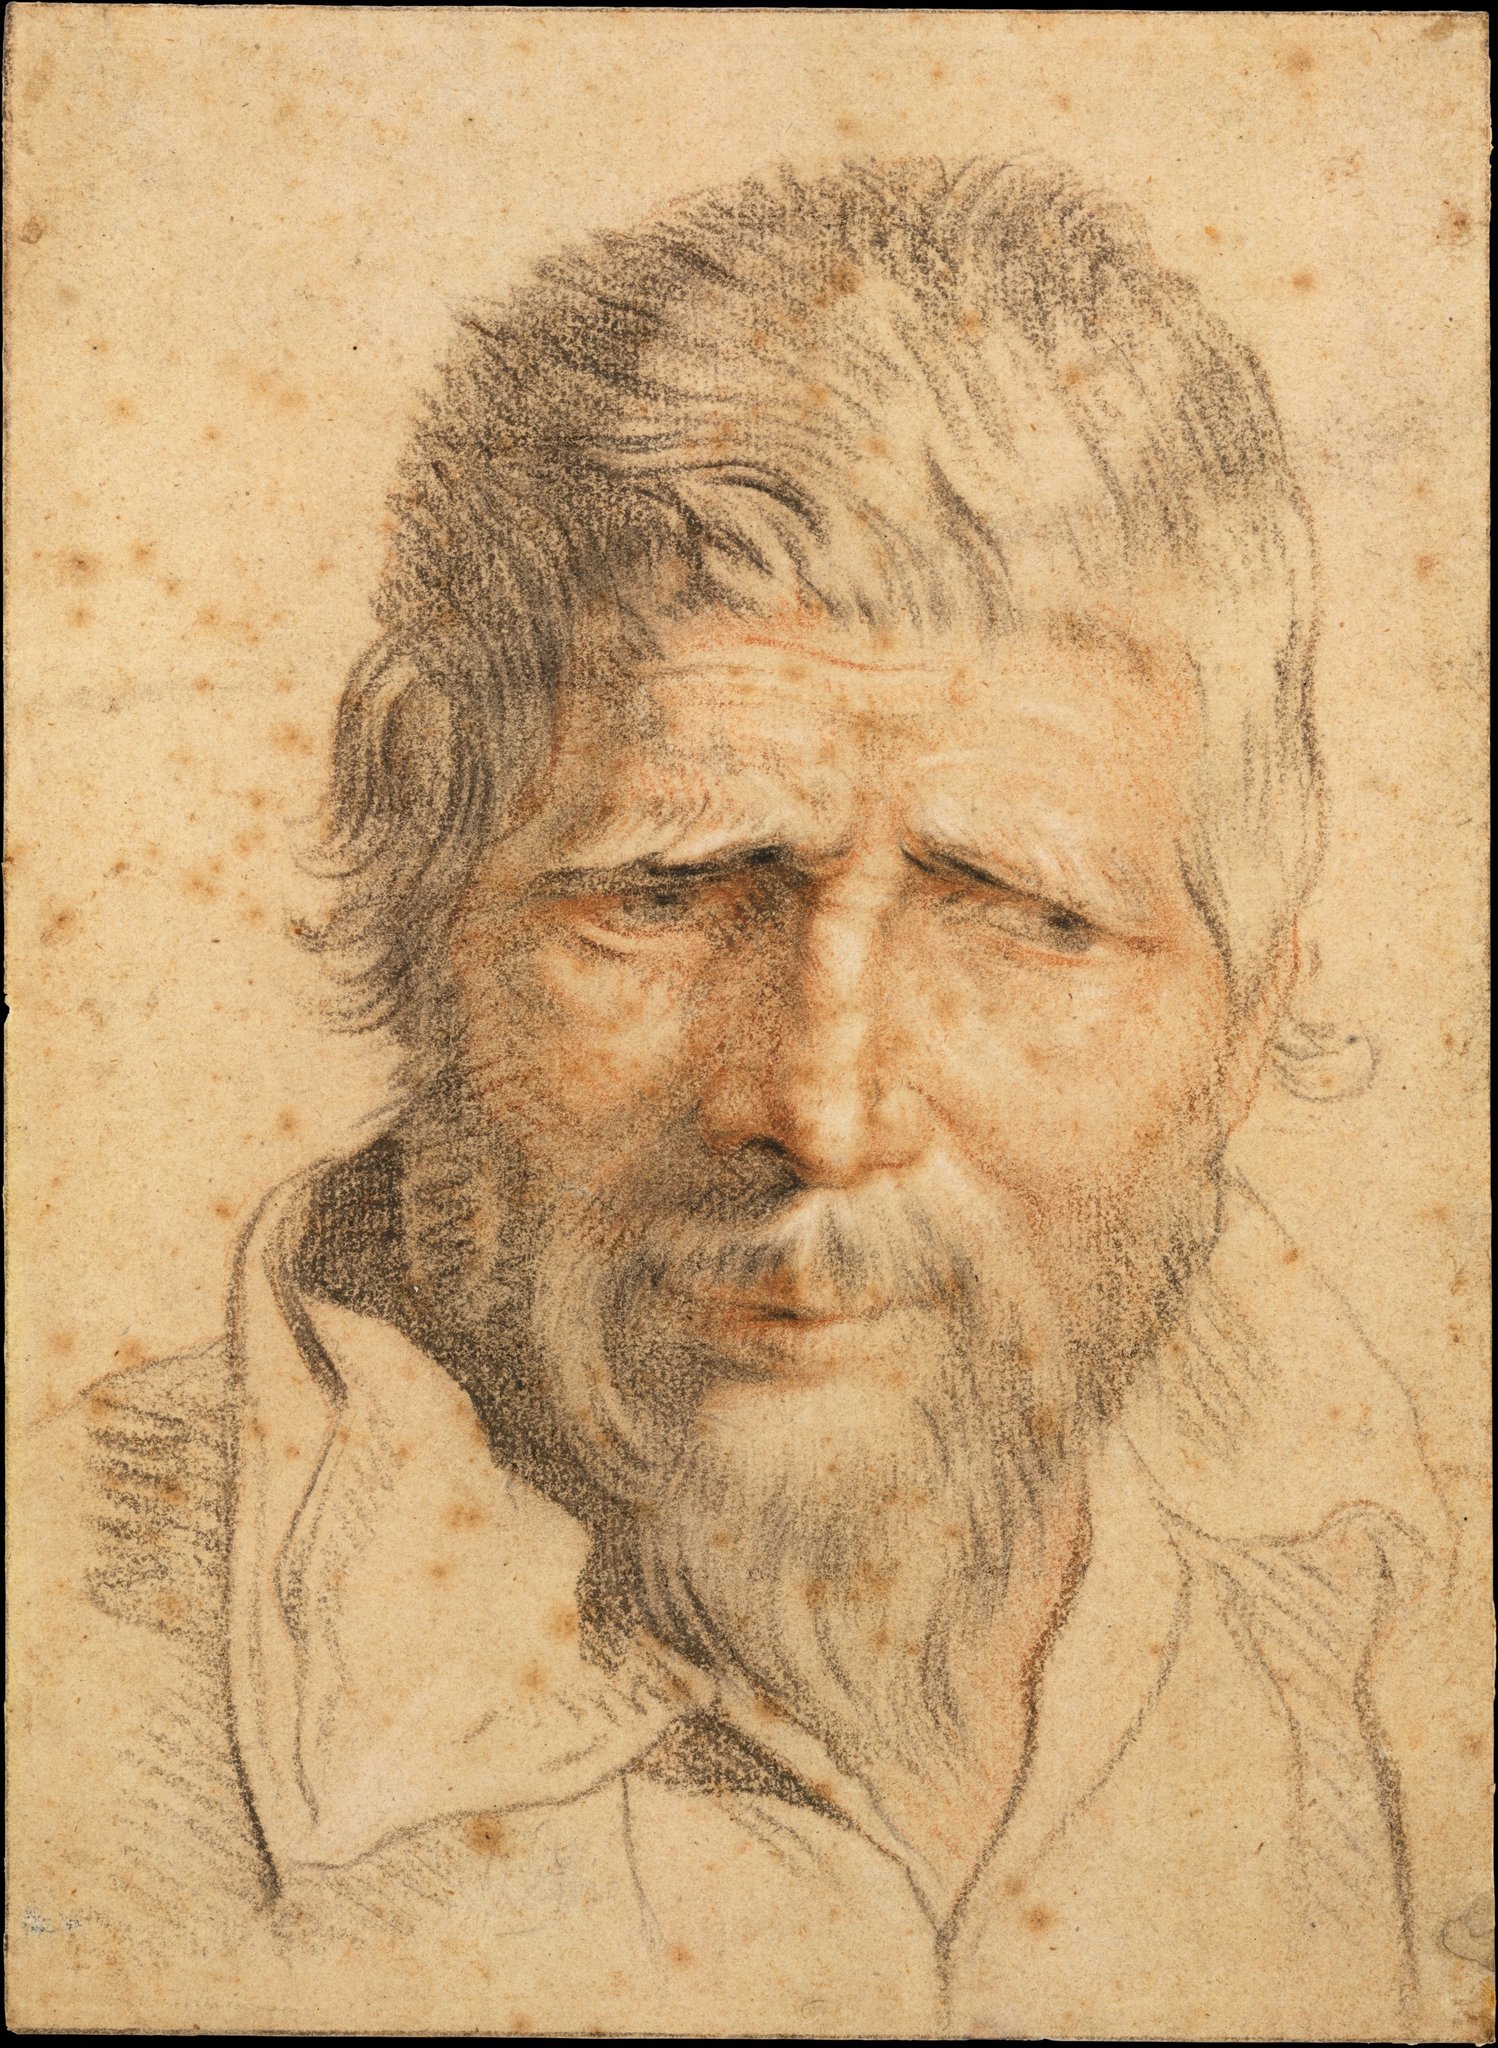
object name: drawing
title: Head of a Man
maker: flemish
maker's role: artist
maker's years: 1550-1600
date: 1634-1666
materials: chalk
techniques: heightening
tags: men,portraits